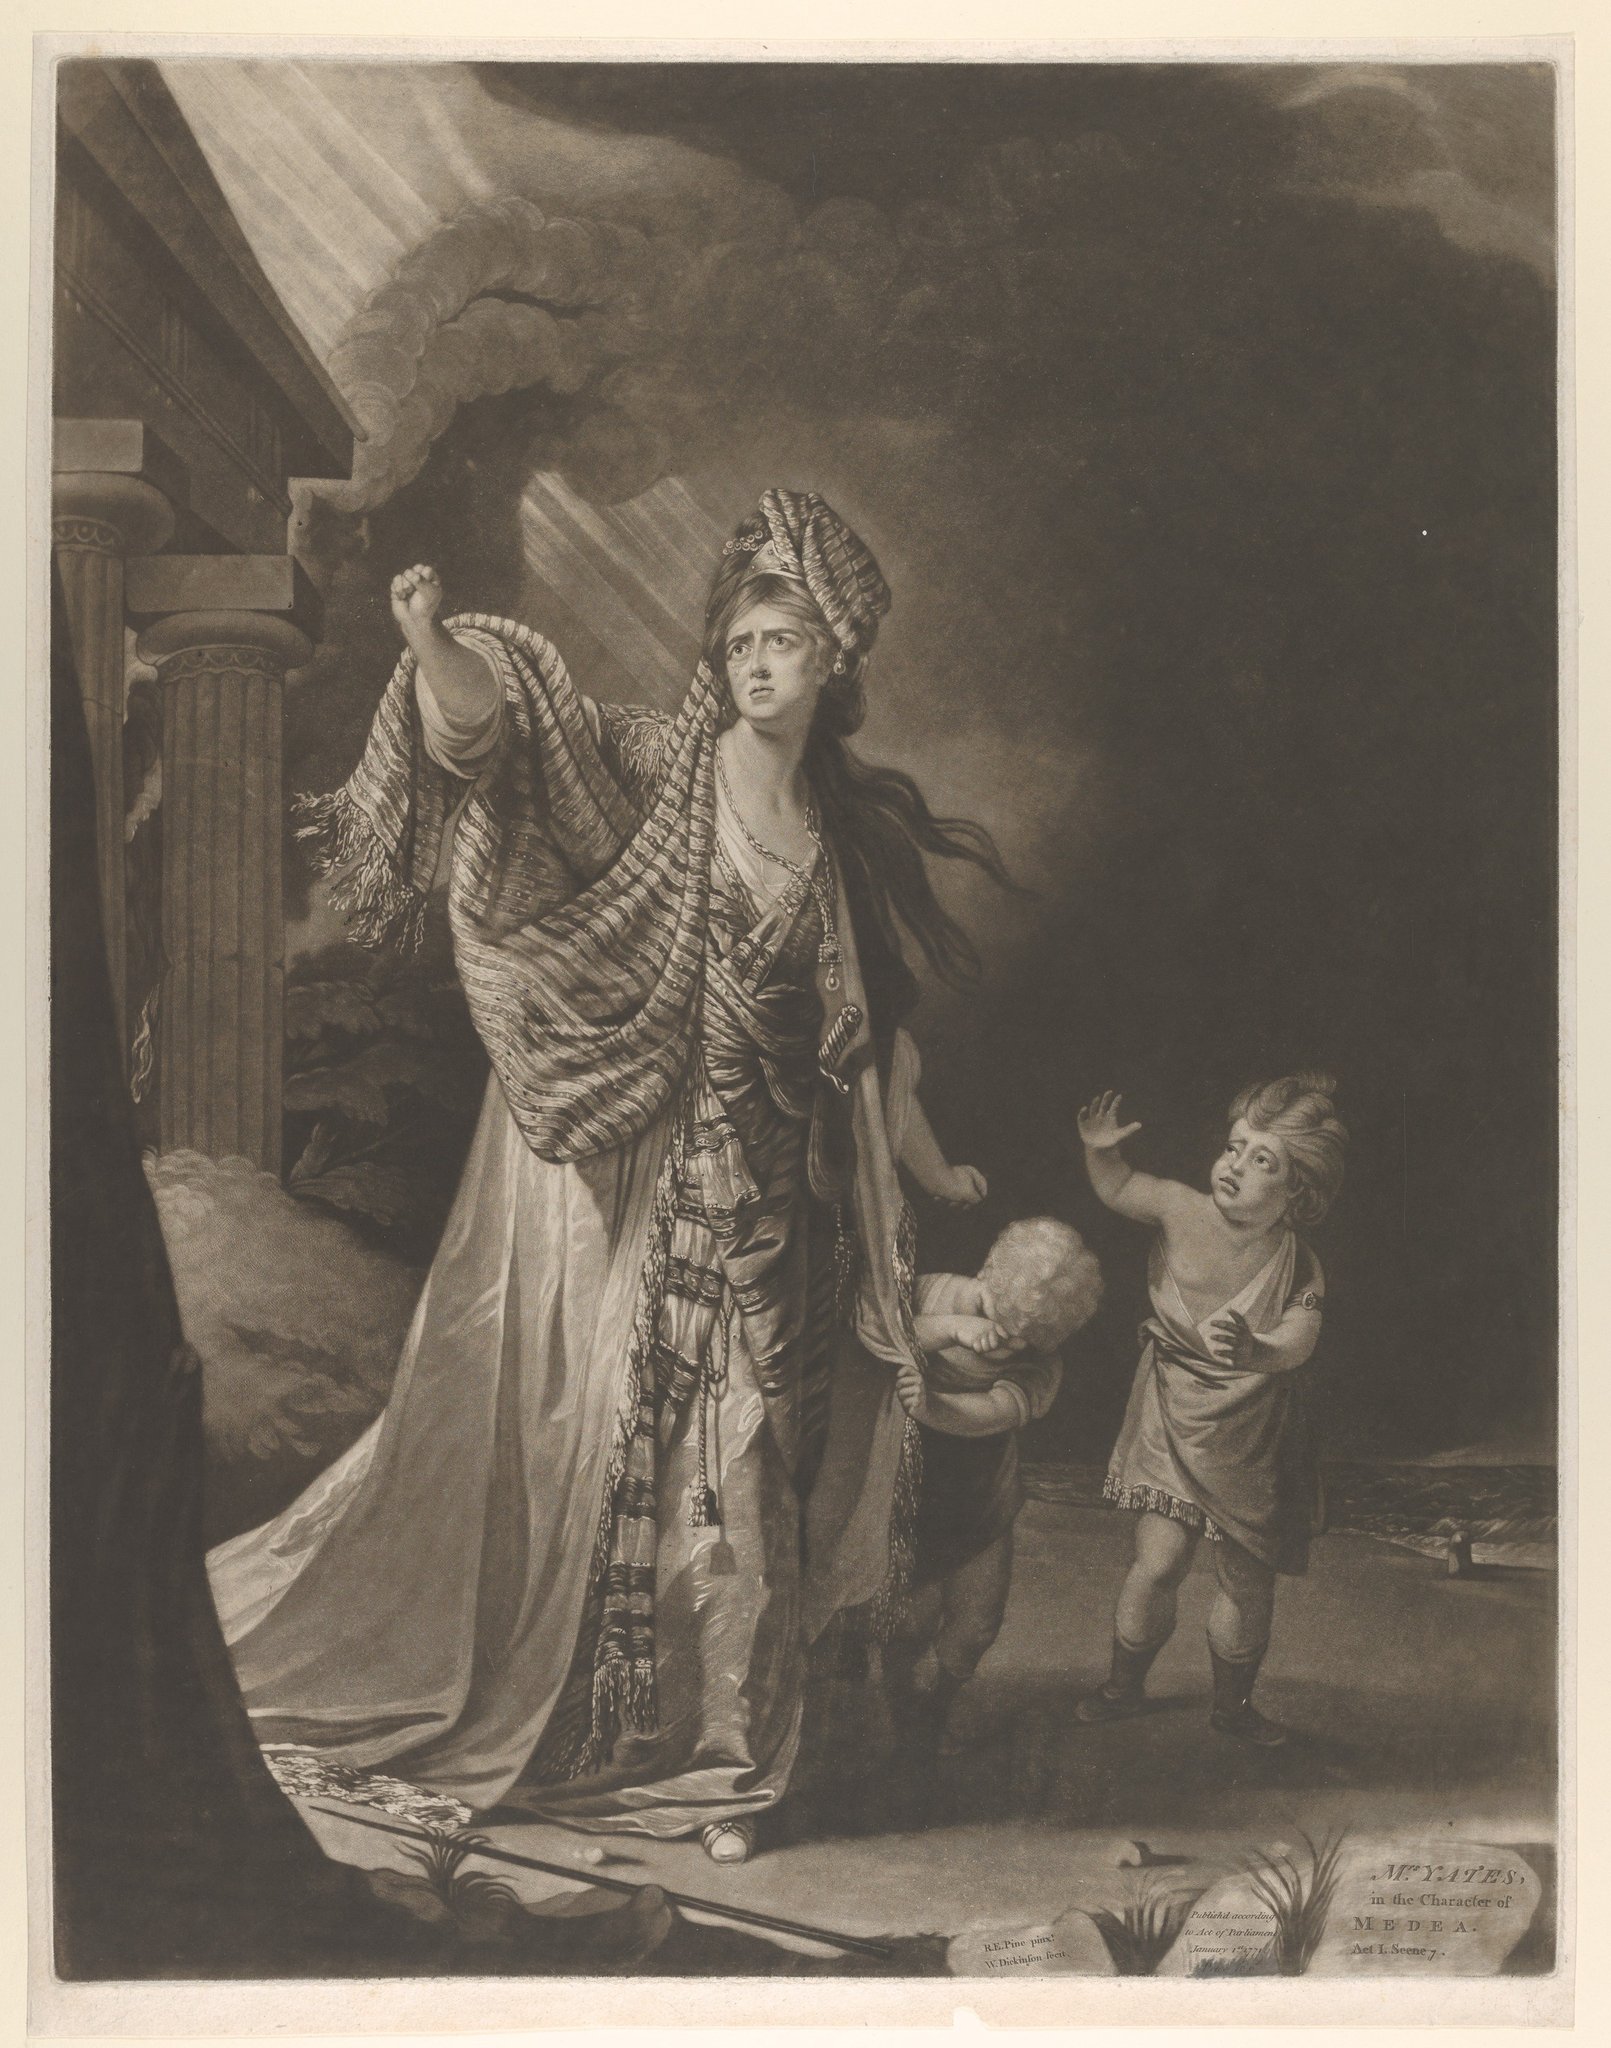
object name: print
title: Mrs. Yates in the Characer of Medea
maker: william dickinson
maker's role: artist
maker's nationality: british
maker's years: 1746-1823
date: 1771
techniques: mezzotint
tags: boys,women,actresses